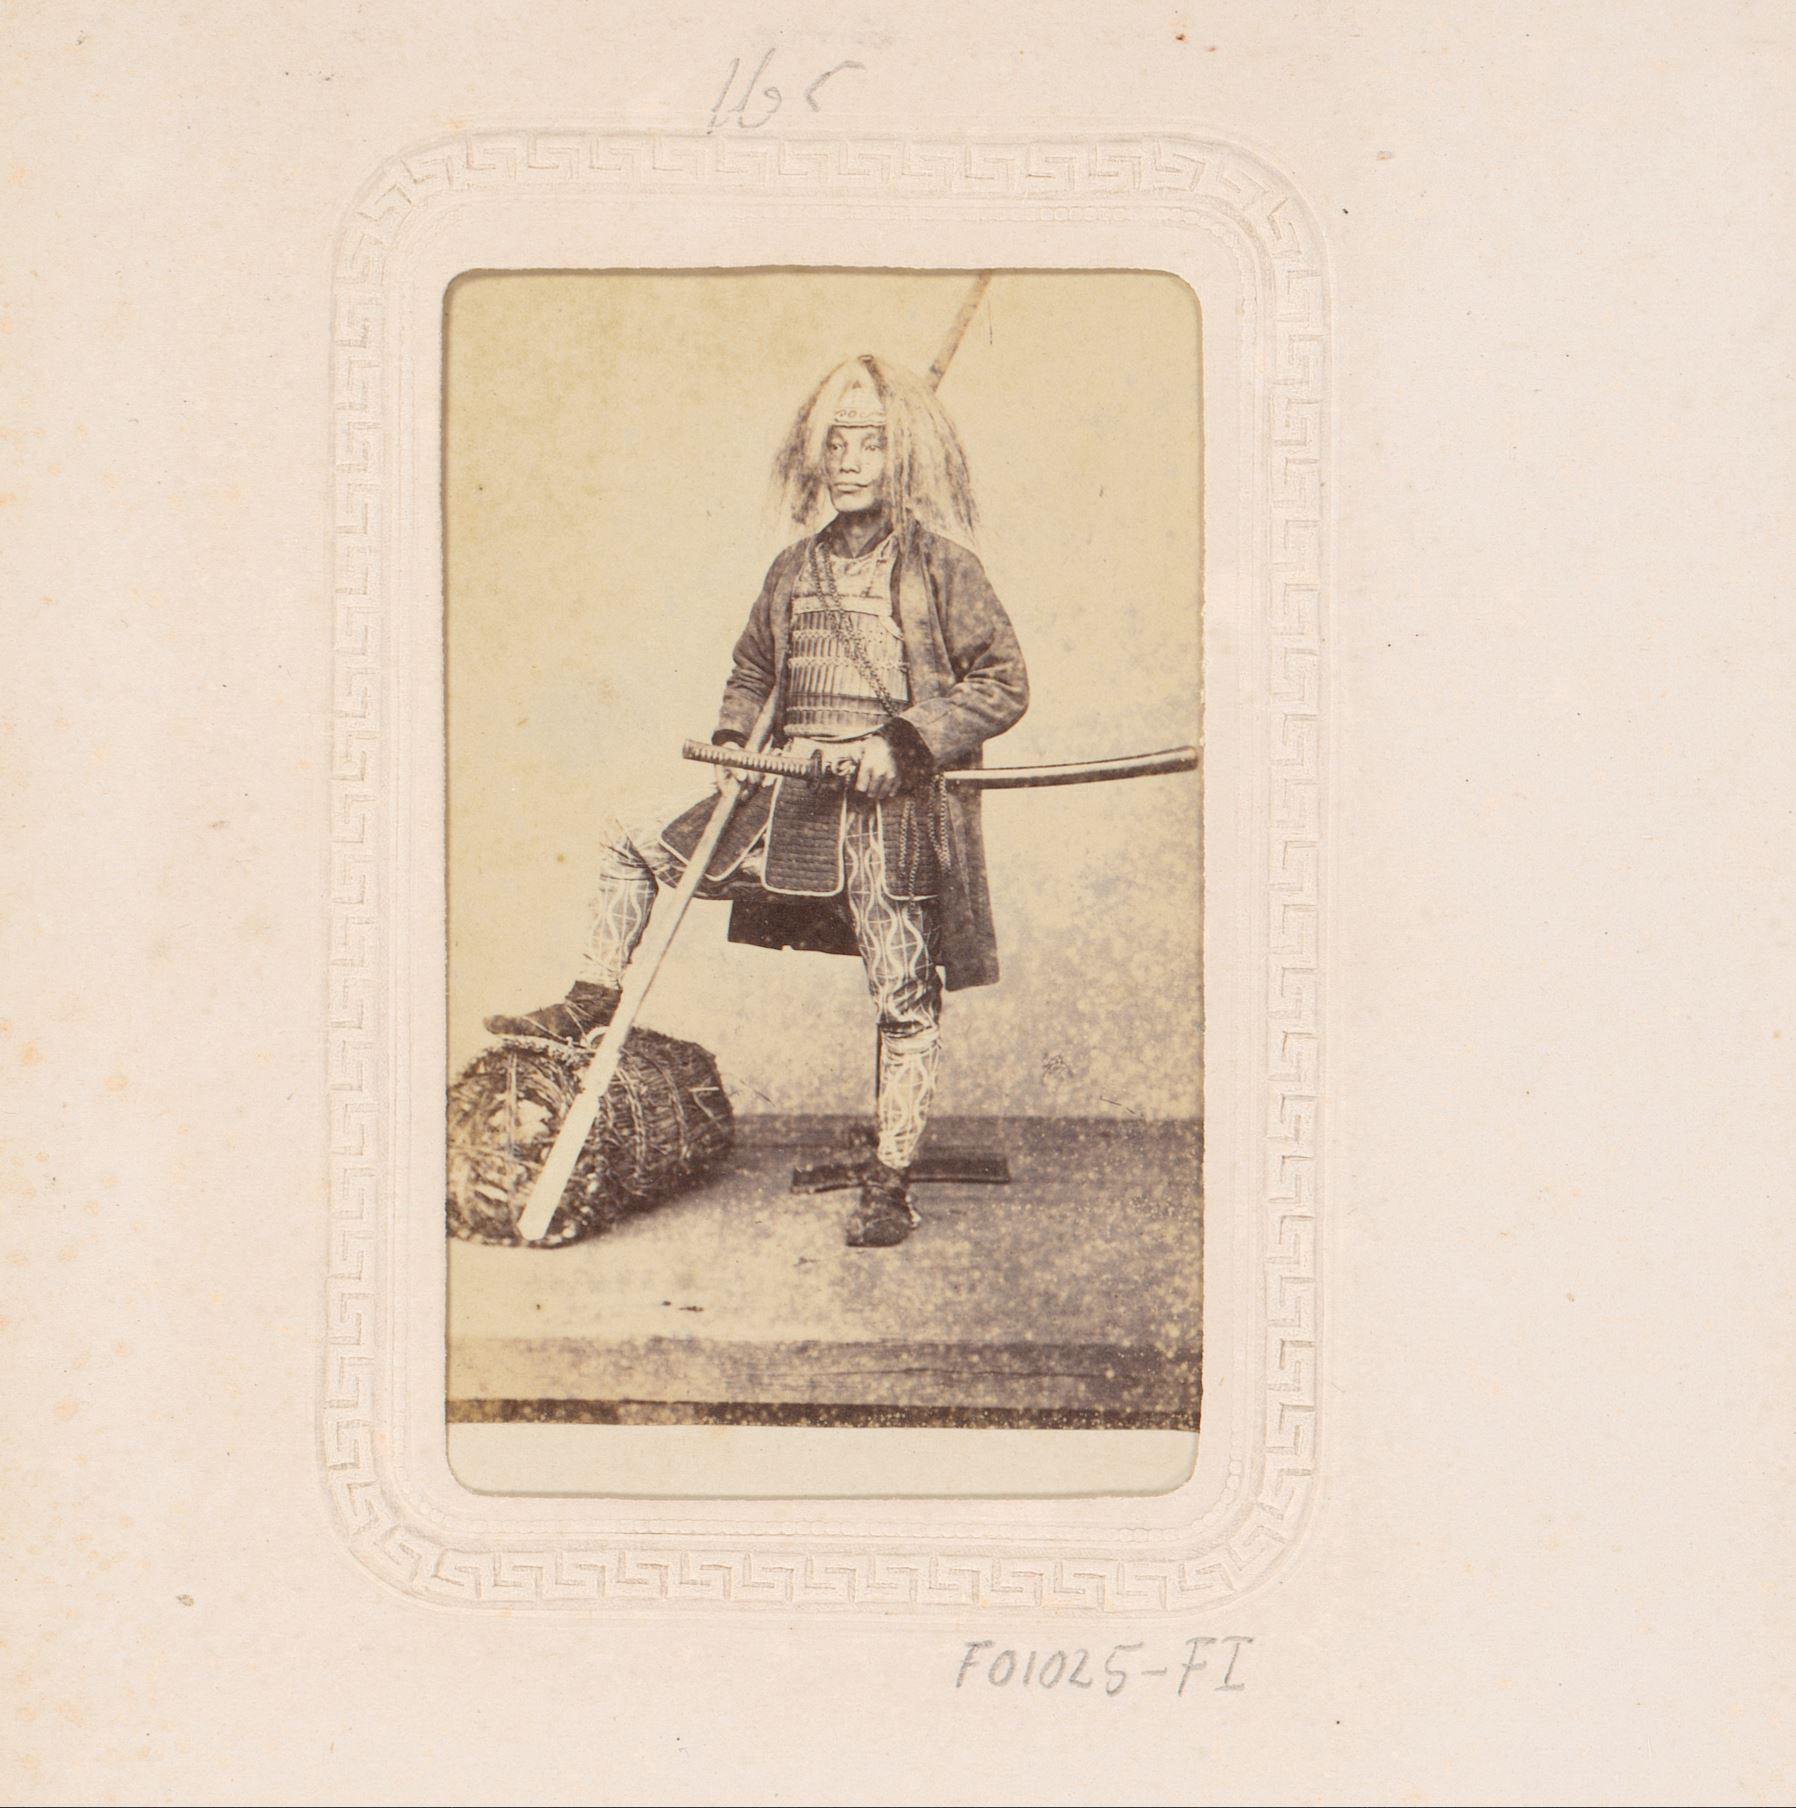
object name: carte de visite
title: Portret van een Japanse krijger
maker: Anonymous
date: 1850-1880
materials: cardboard, photographic support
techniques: albumen print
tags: adult man, historical persons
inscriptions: number: ‘165’